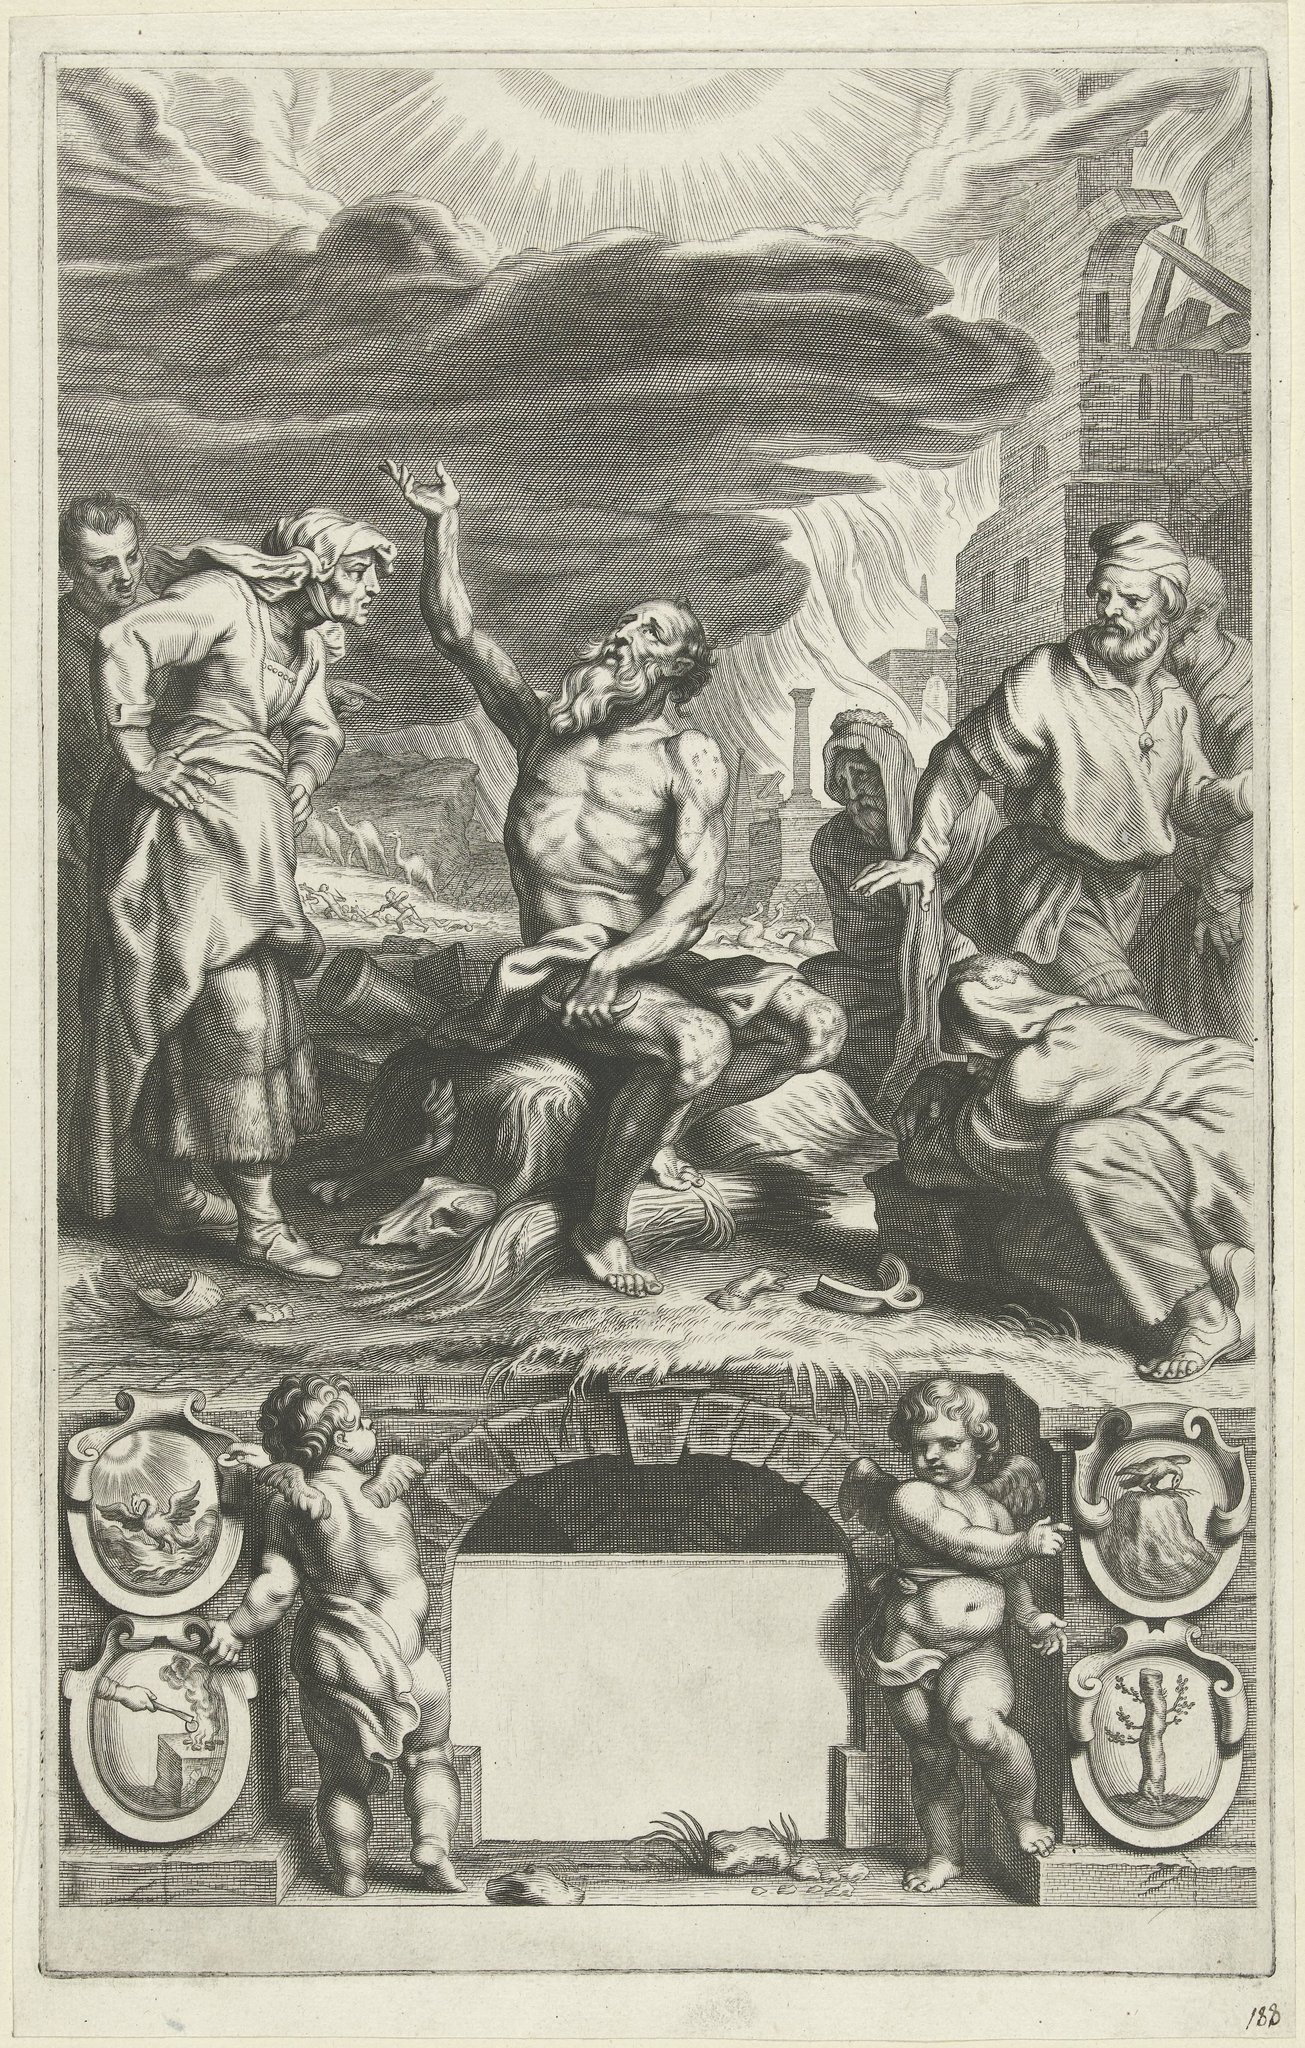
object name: print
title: Job wordt door zijn vrouw uitgescholden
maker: cornelis galle (ii)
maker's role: print maker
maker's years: 1615-1678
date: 1646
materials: paper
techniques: engraving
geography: antwerp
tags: job covered with sores (or boils) takes his abode on a dunghill (pile of ashes) and scrapes his body with a potsherd, job on the dunghill visited by his wife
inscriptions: collector's mark: Lugt 240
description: Job zit op de grond, zijn lichaam is met zweren bedekt en zijn huis is afgebrand. Zijn vrouw staat naast hem en schelt hem uit. Zijn vrienden keren zich van hem af. Boven de donkere wolken aan de hemel breekt de zon door. Onder een catacombe met de titel van het boek en twee putti die emblemen vasthouden.